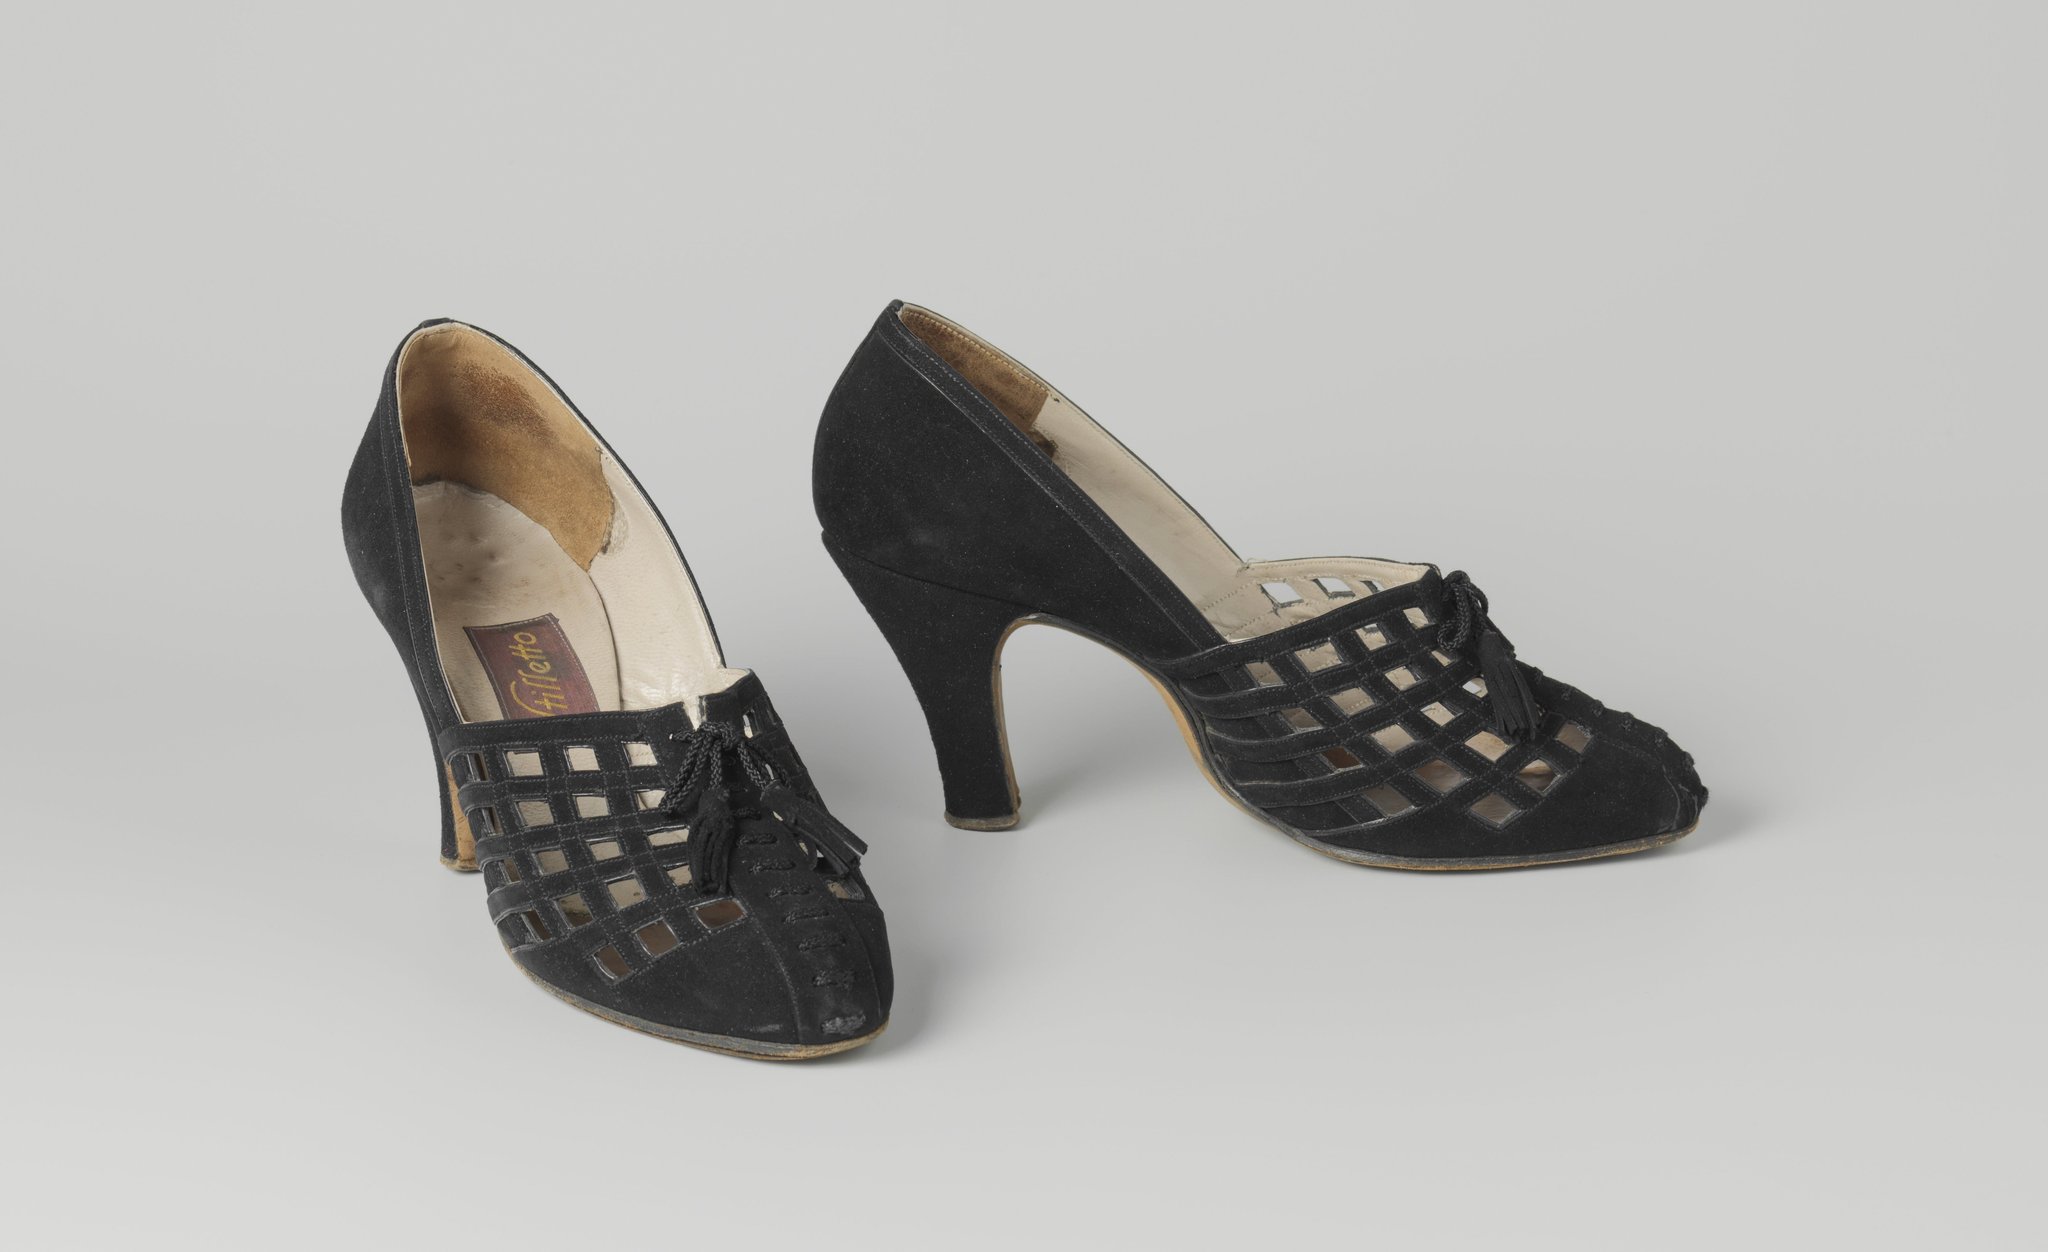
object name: womenswear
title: Pair of shoes with lattice instep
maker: Anonymous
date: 1920-1930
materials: leather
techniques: braiding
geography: netherlands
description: Geldt ook voor BK-1975-429-A.